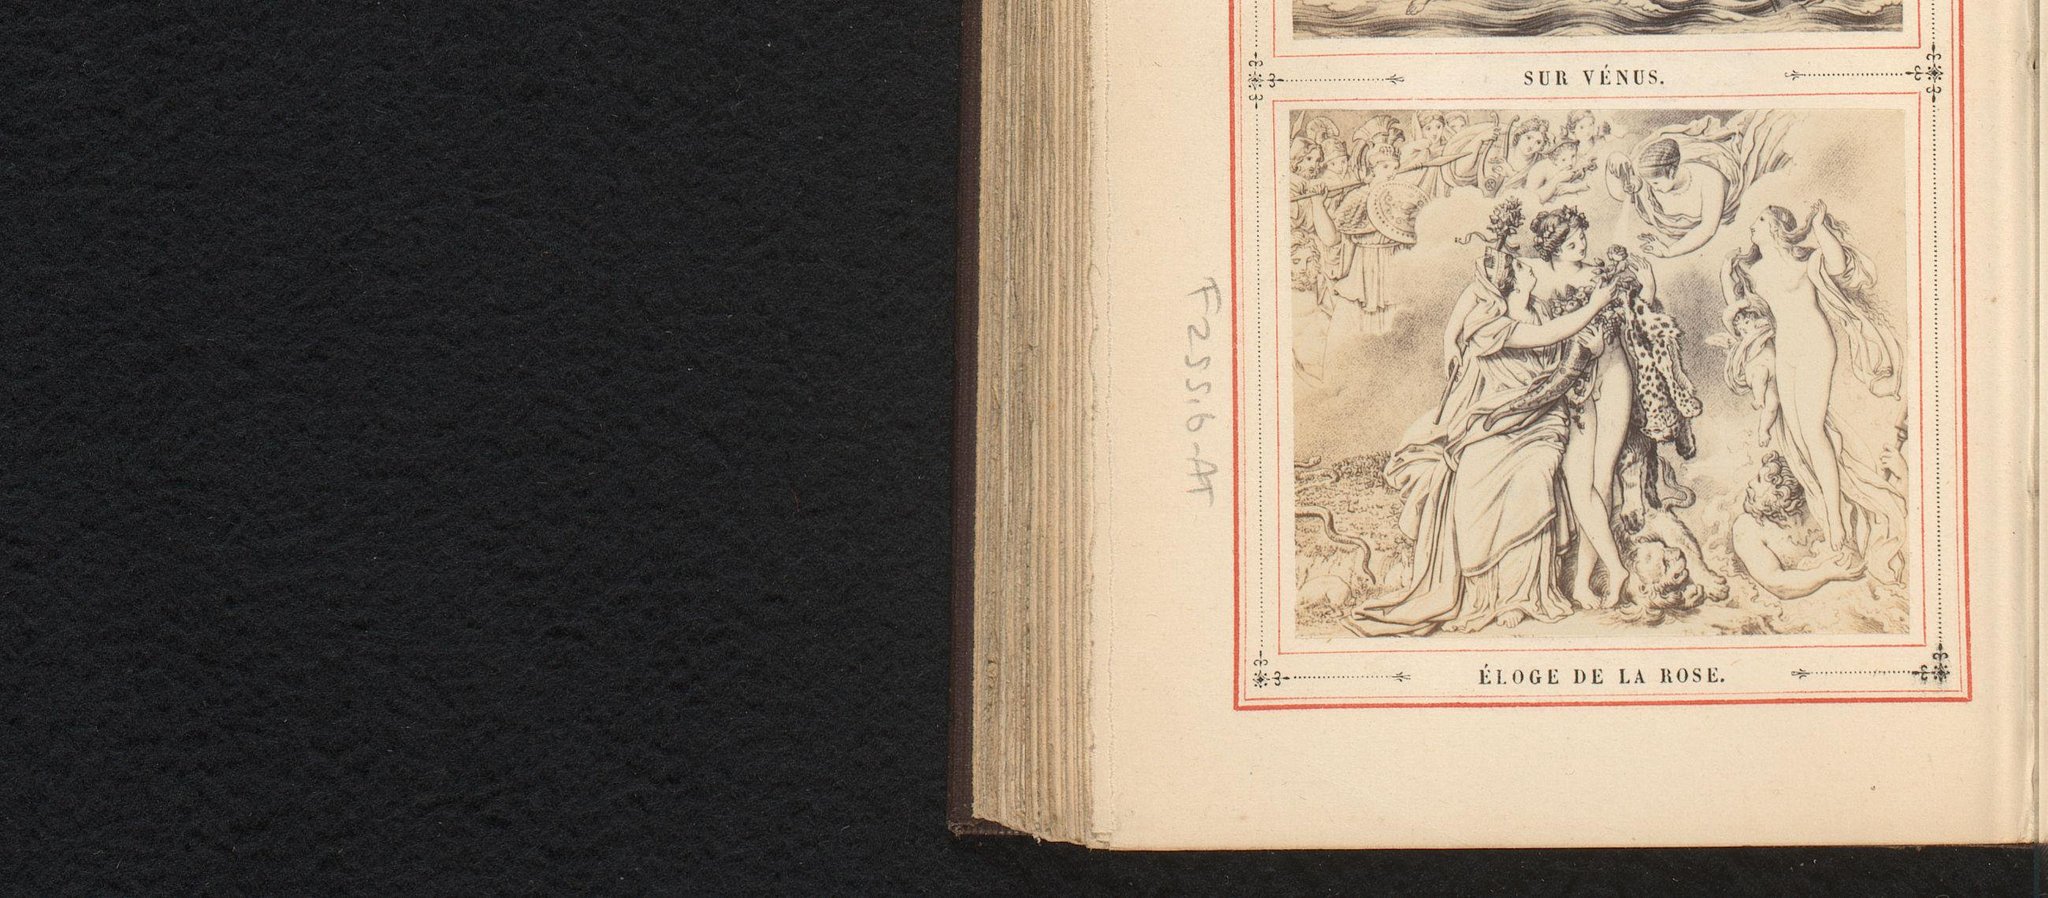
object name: photograph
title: Fotoreproductie van een tekening van Girodet, goden eren een roos, illustratie bij Apothéose d'Anacréon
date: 1859-1864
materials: paper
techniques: albumen print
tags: gods ~ classical mythology